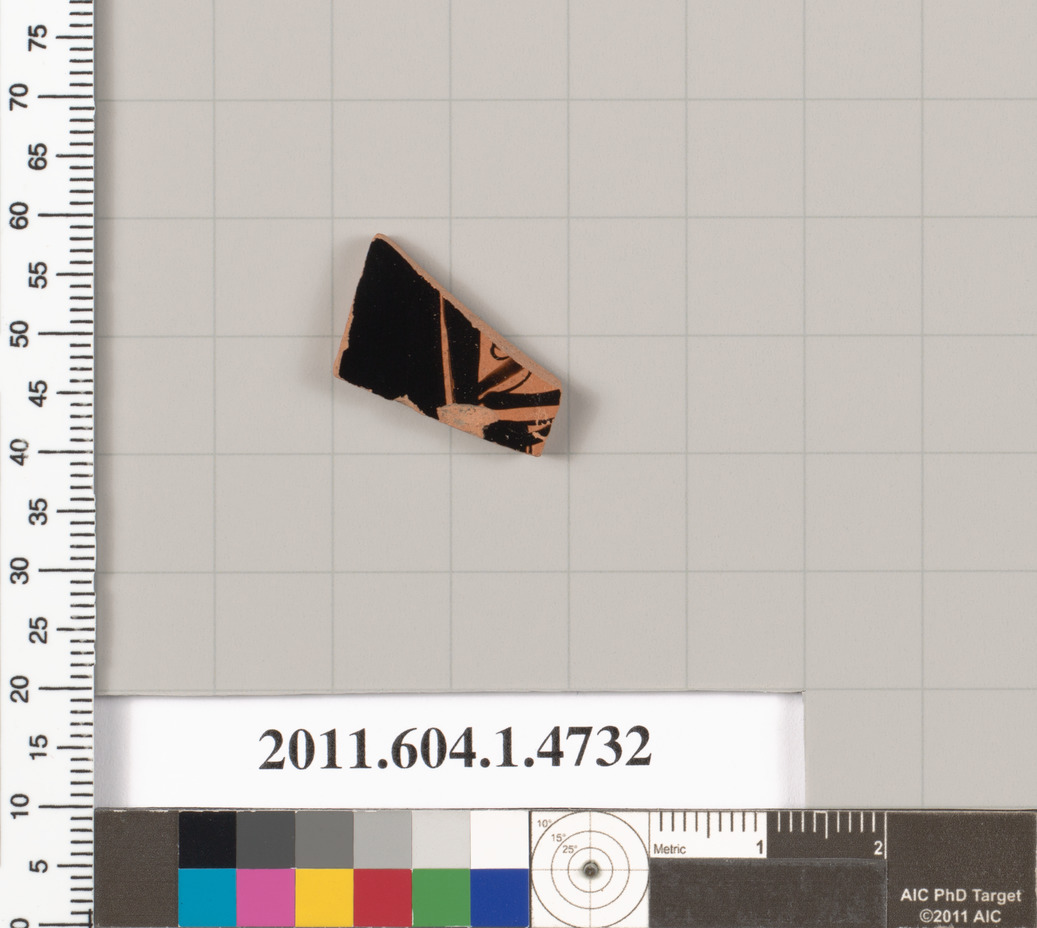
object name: kylix fragment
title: Terracotta fragment of a kylix (drinking cup)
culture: greek, attic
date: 475-451 BCE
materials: terracotta